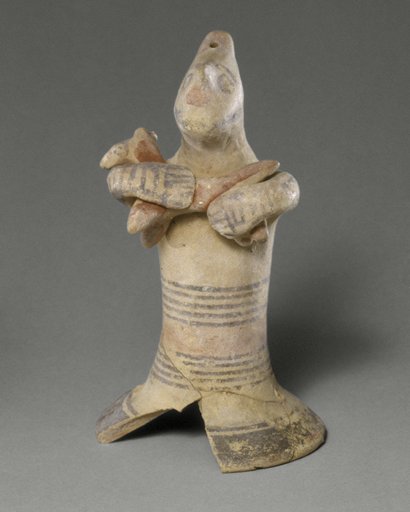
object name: figurine of a man holding an animal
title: Terracotta statuette of a man holding a quadruped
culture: cypriot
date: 750-600 BCE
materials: terracotta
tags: animals,men